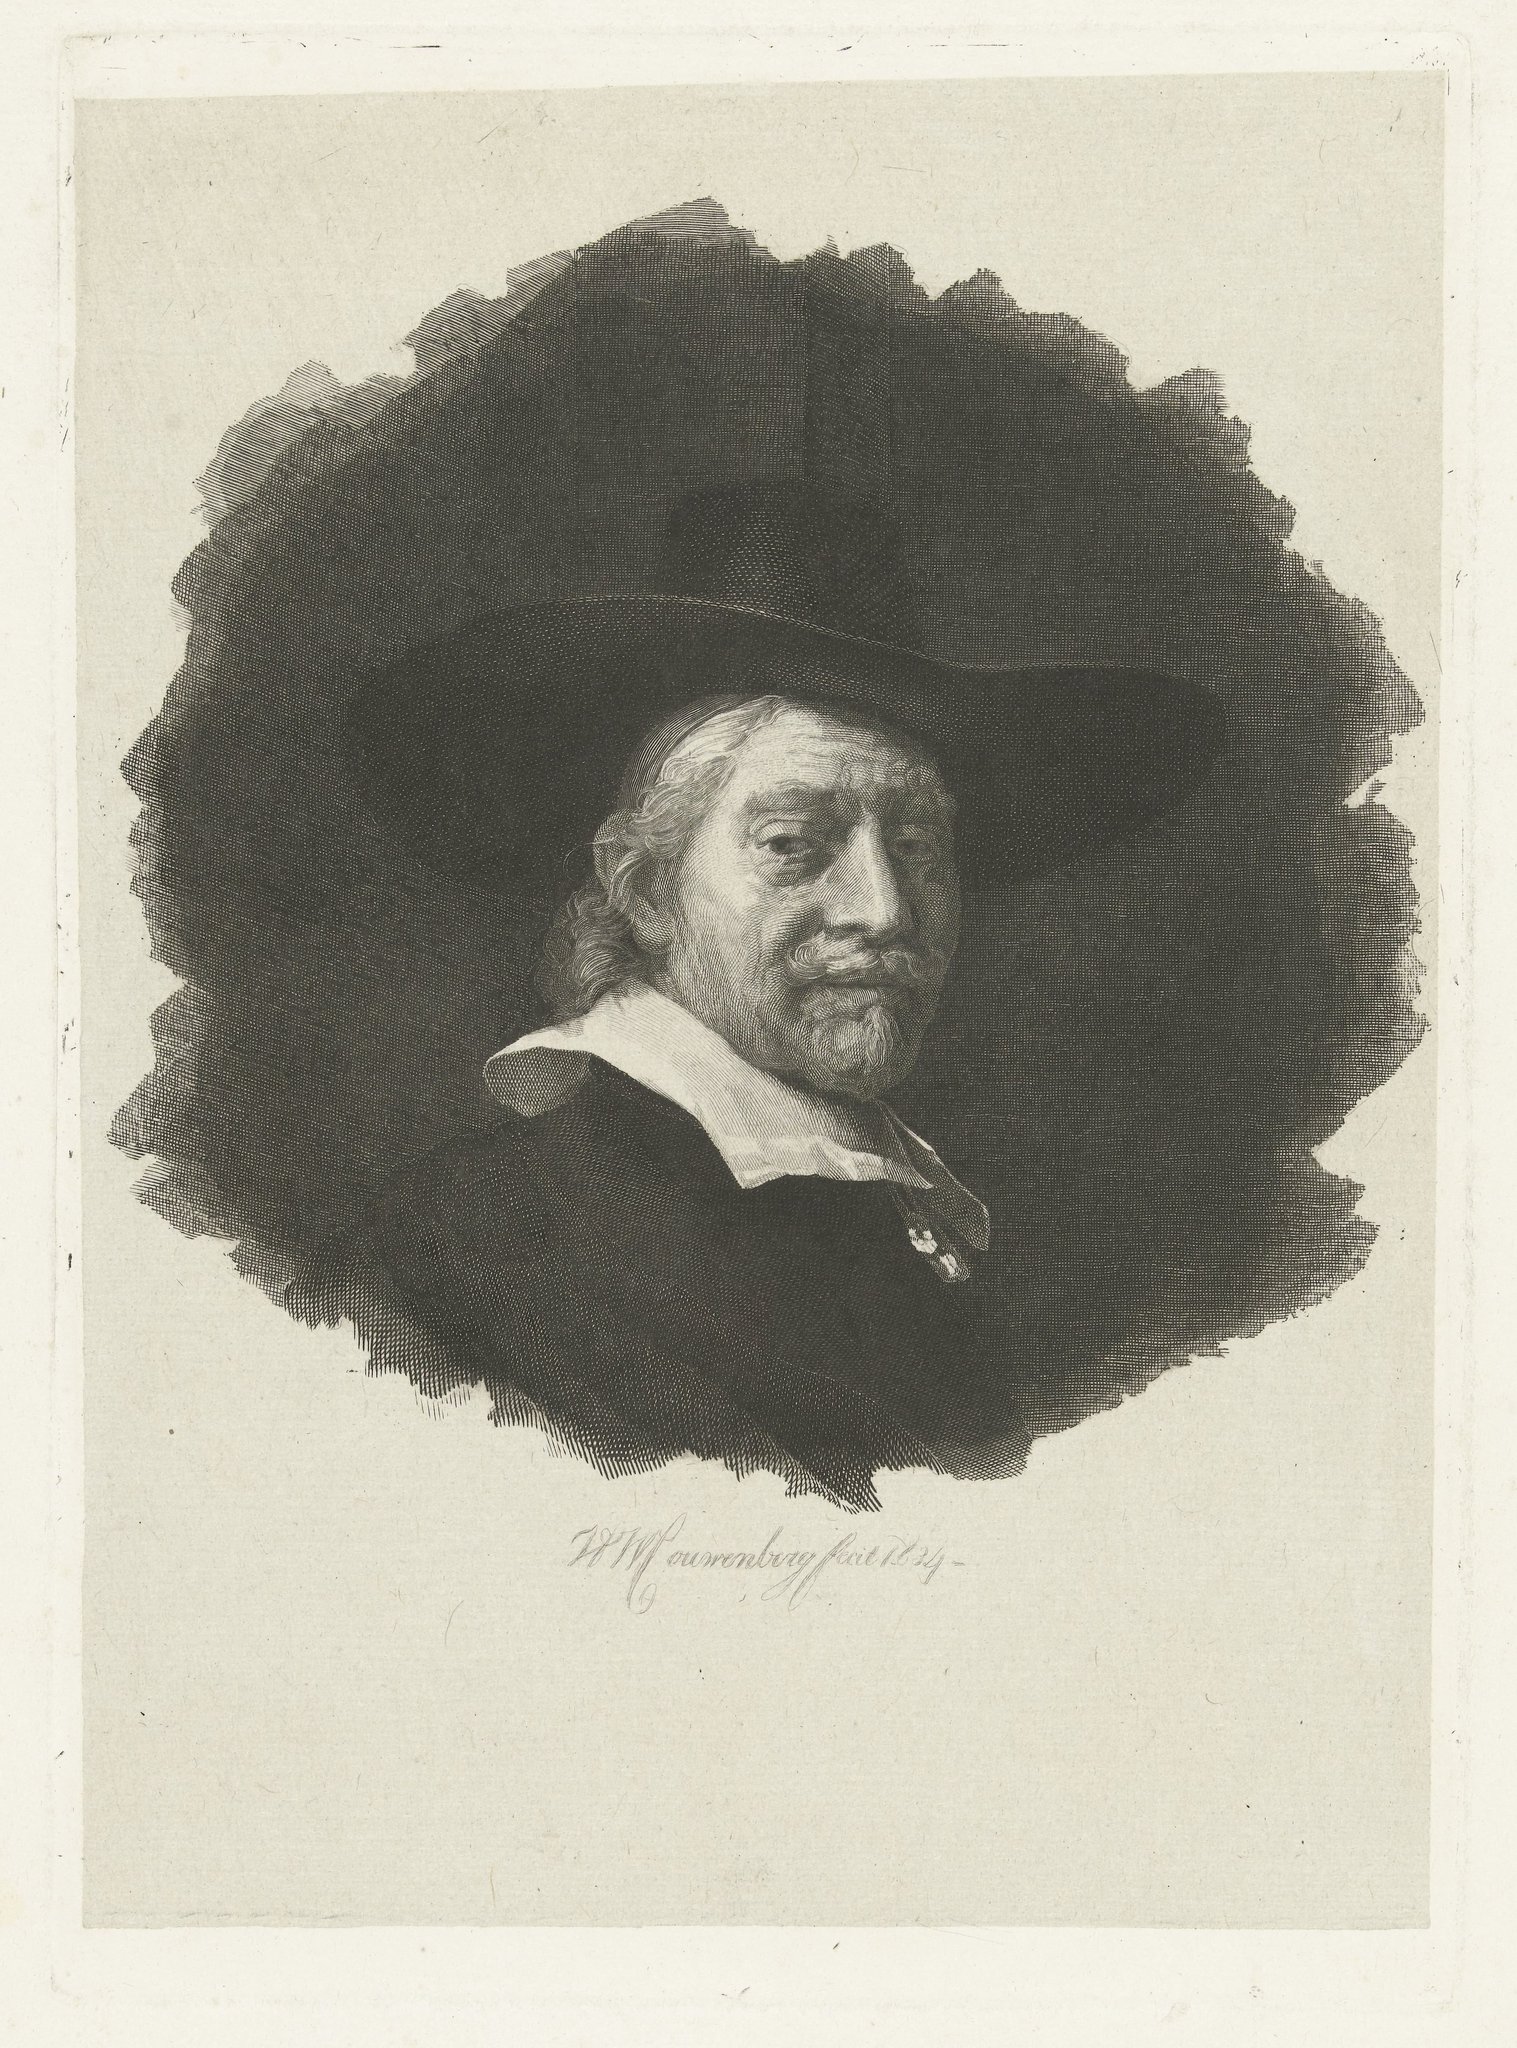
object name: print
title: Portret van een staalmeester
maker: henricus wilhelmus couwenberg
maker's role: draughtsman, print maker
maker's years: 1814-1845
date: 1834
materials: paper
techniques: engraving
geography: amsterdam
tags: anonymous historical person portrayed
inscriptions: collector's mark: Lugt 2228